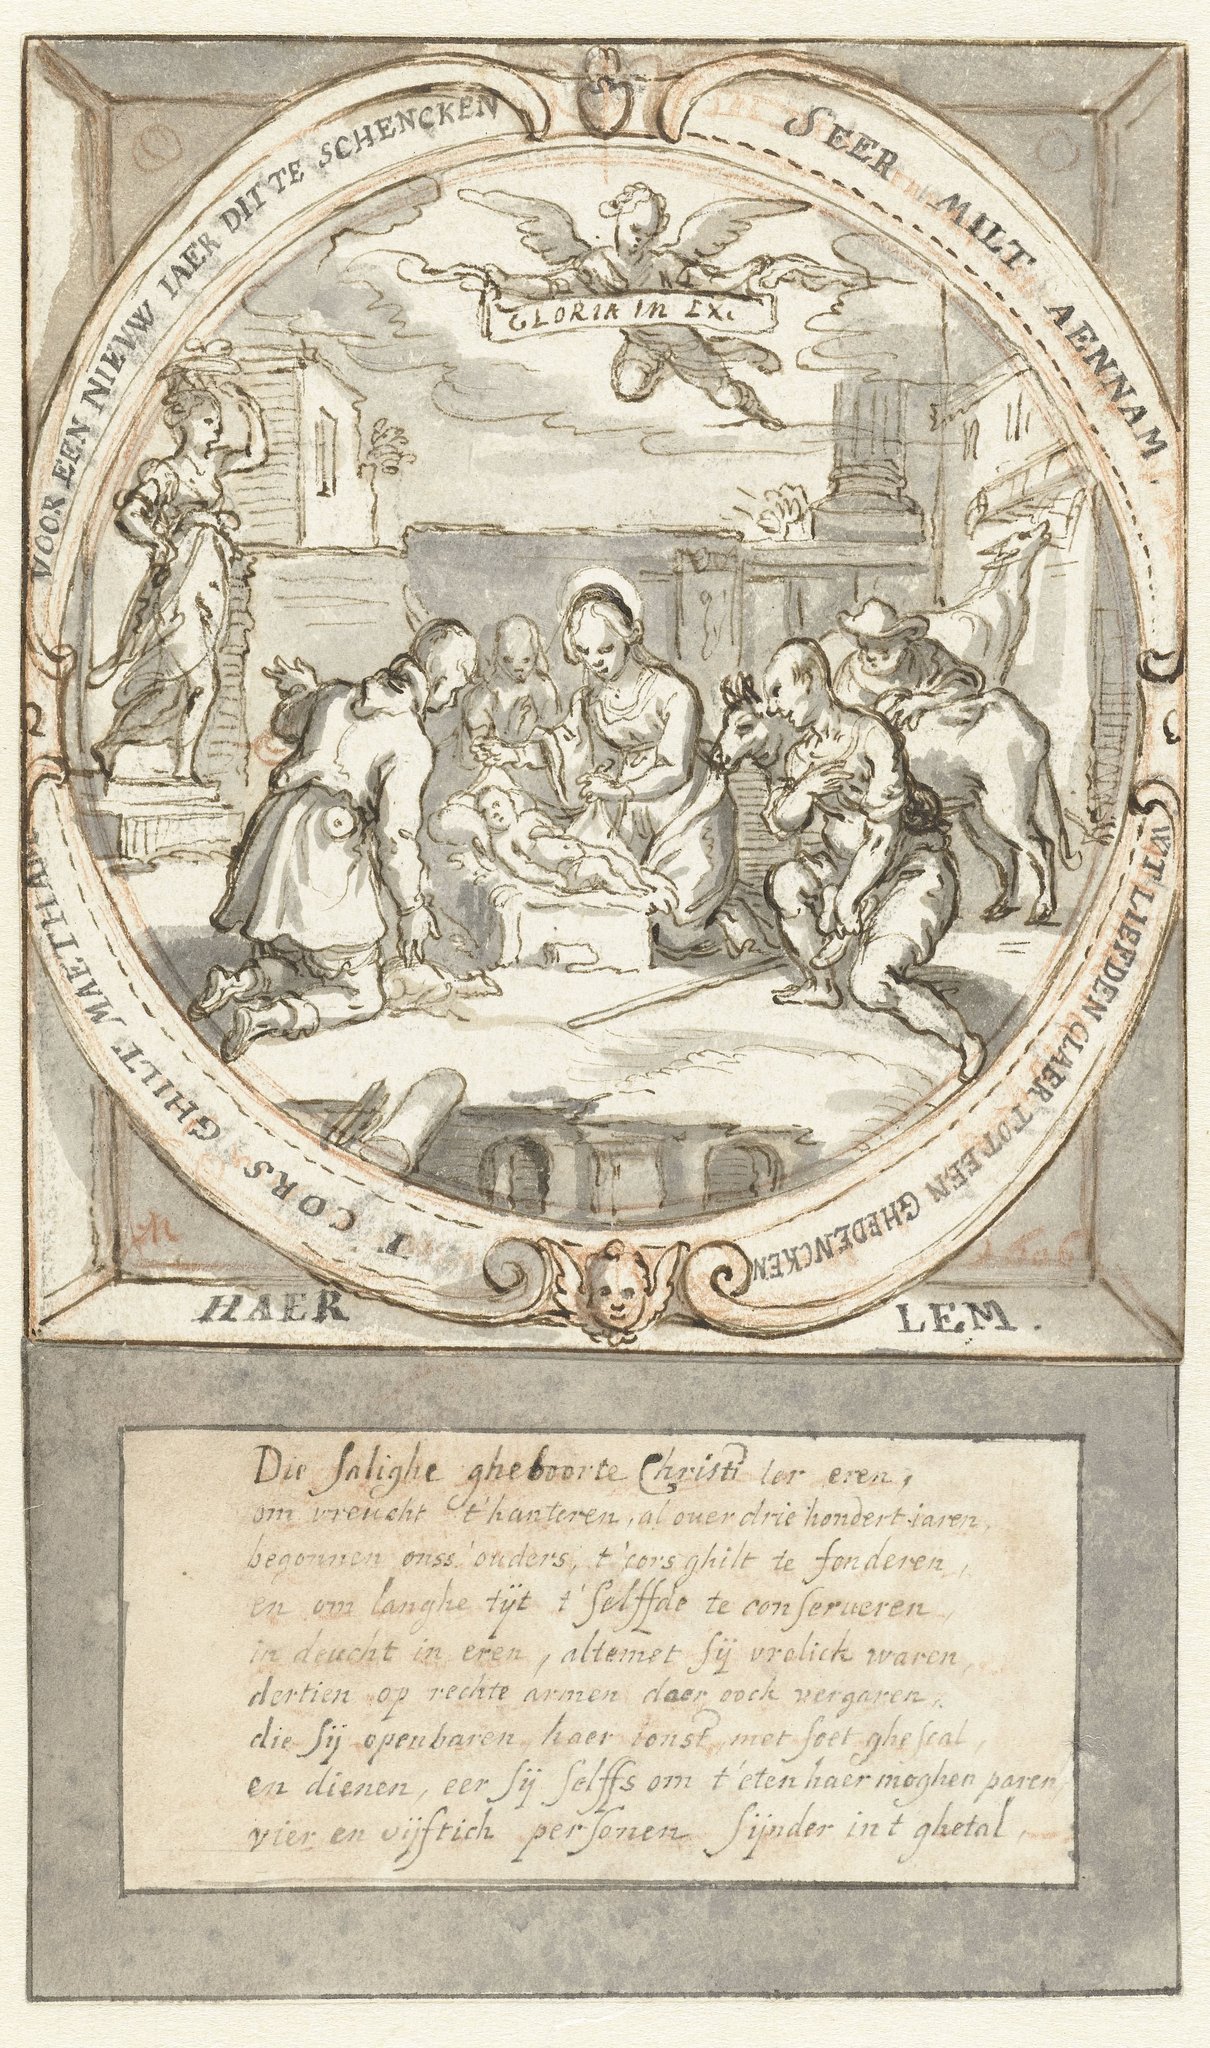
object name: design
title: Aanbidding der herders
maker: jacob matham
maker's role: draughtsman, print maker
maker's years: 1571-1631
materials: chalk, ink, paper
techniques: brush, pen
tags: adoration of the christ-child by the shepherds; mary and joseph present